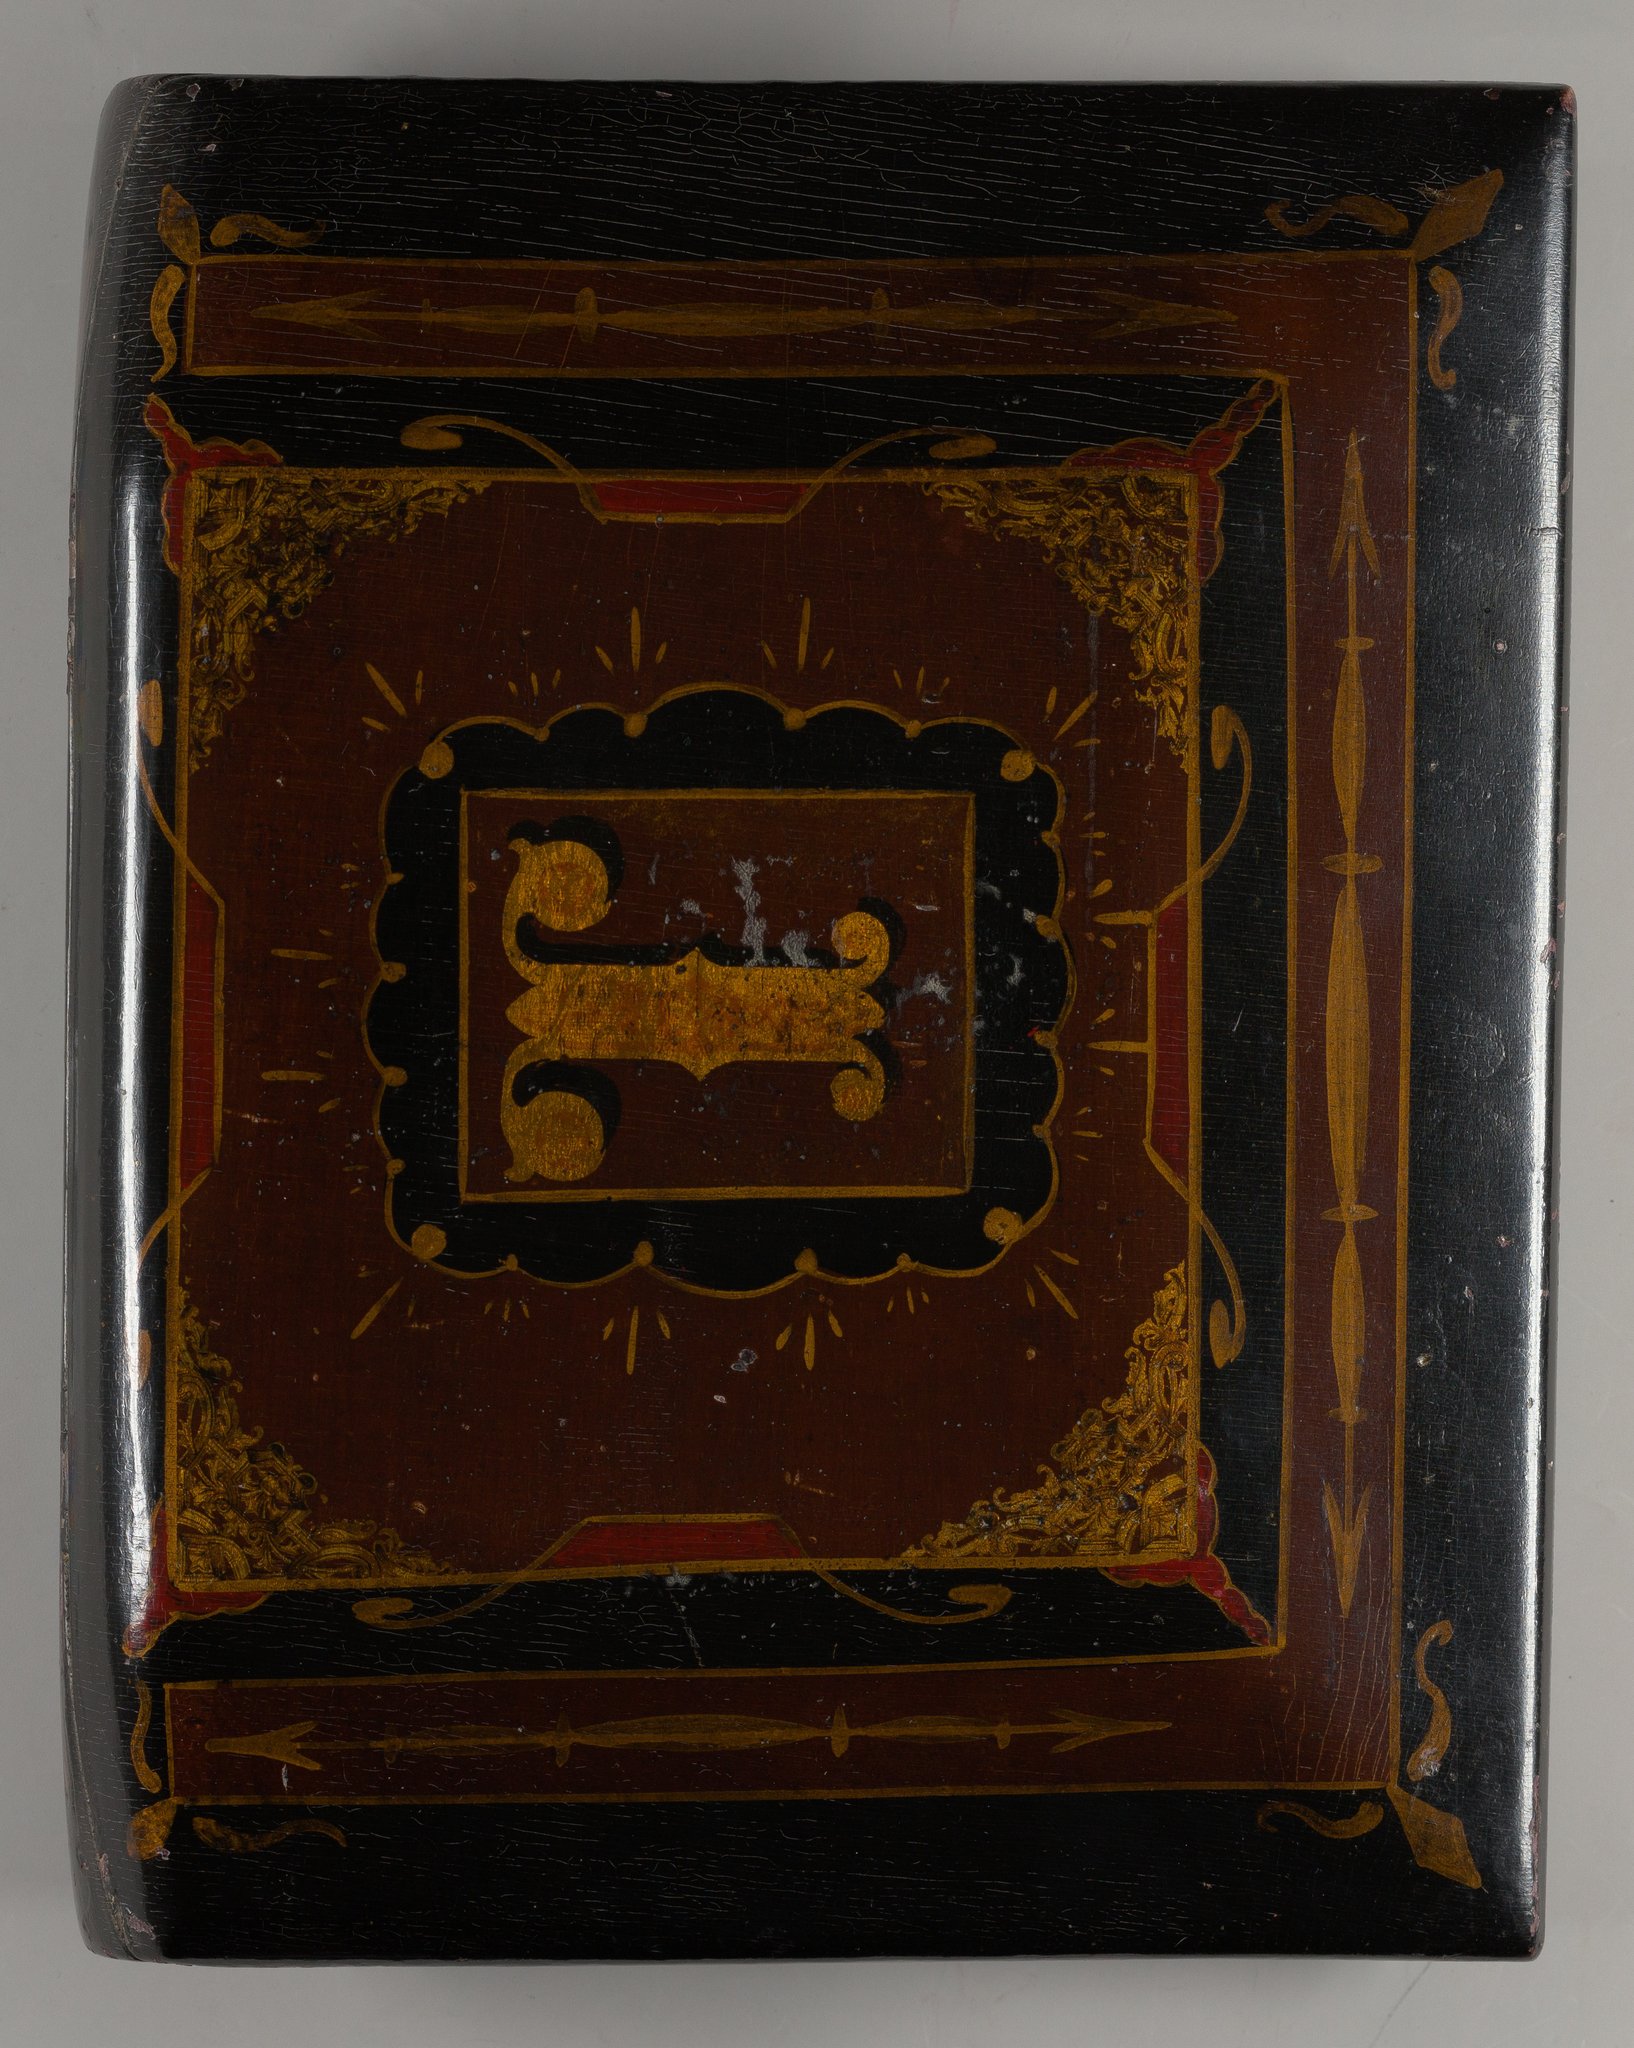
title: Desk or dresser box in book form, painted with the initial "T"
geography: united states